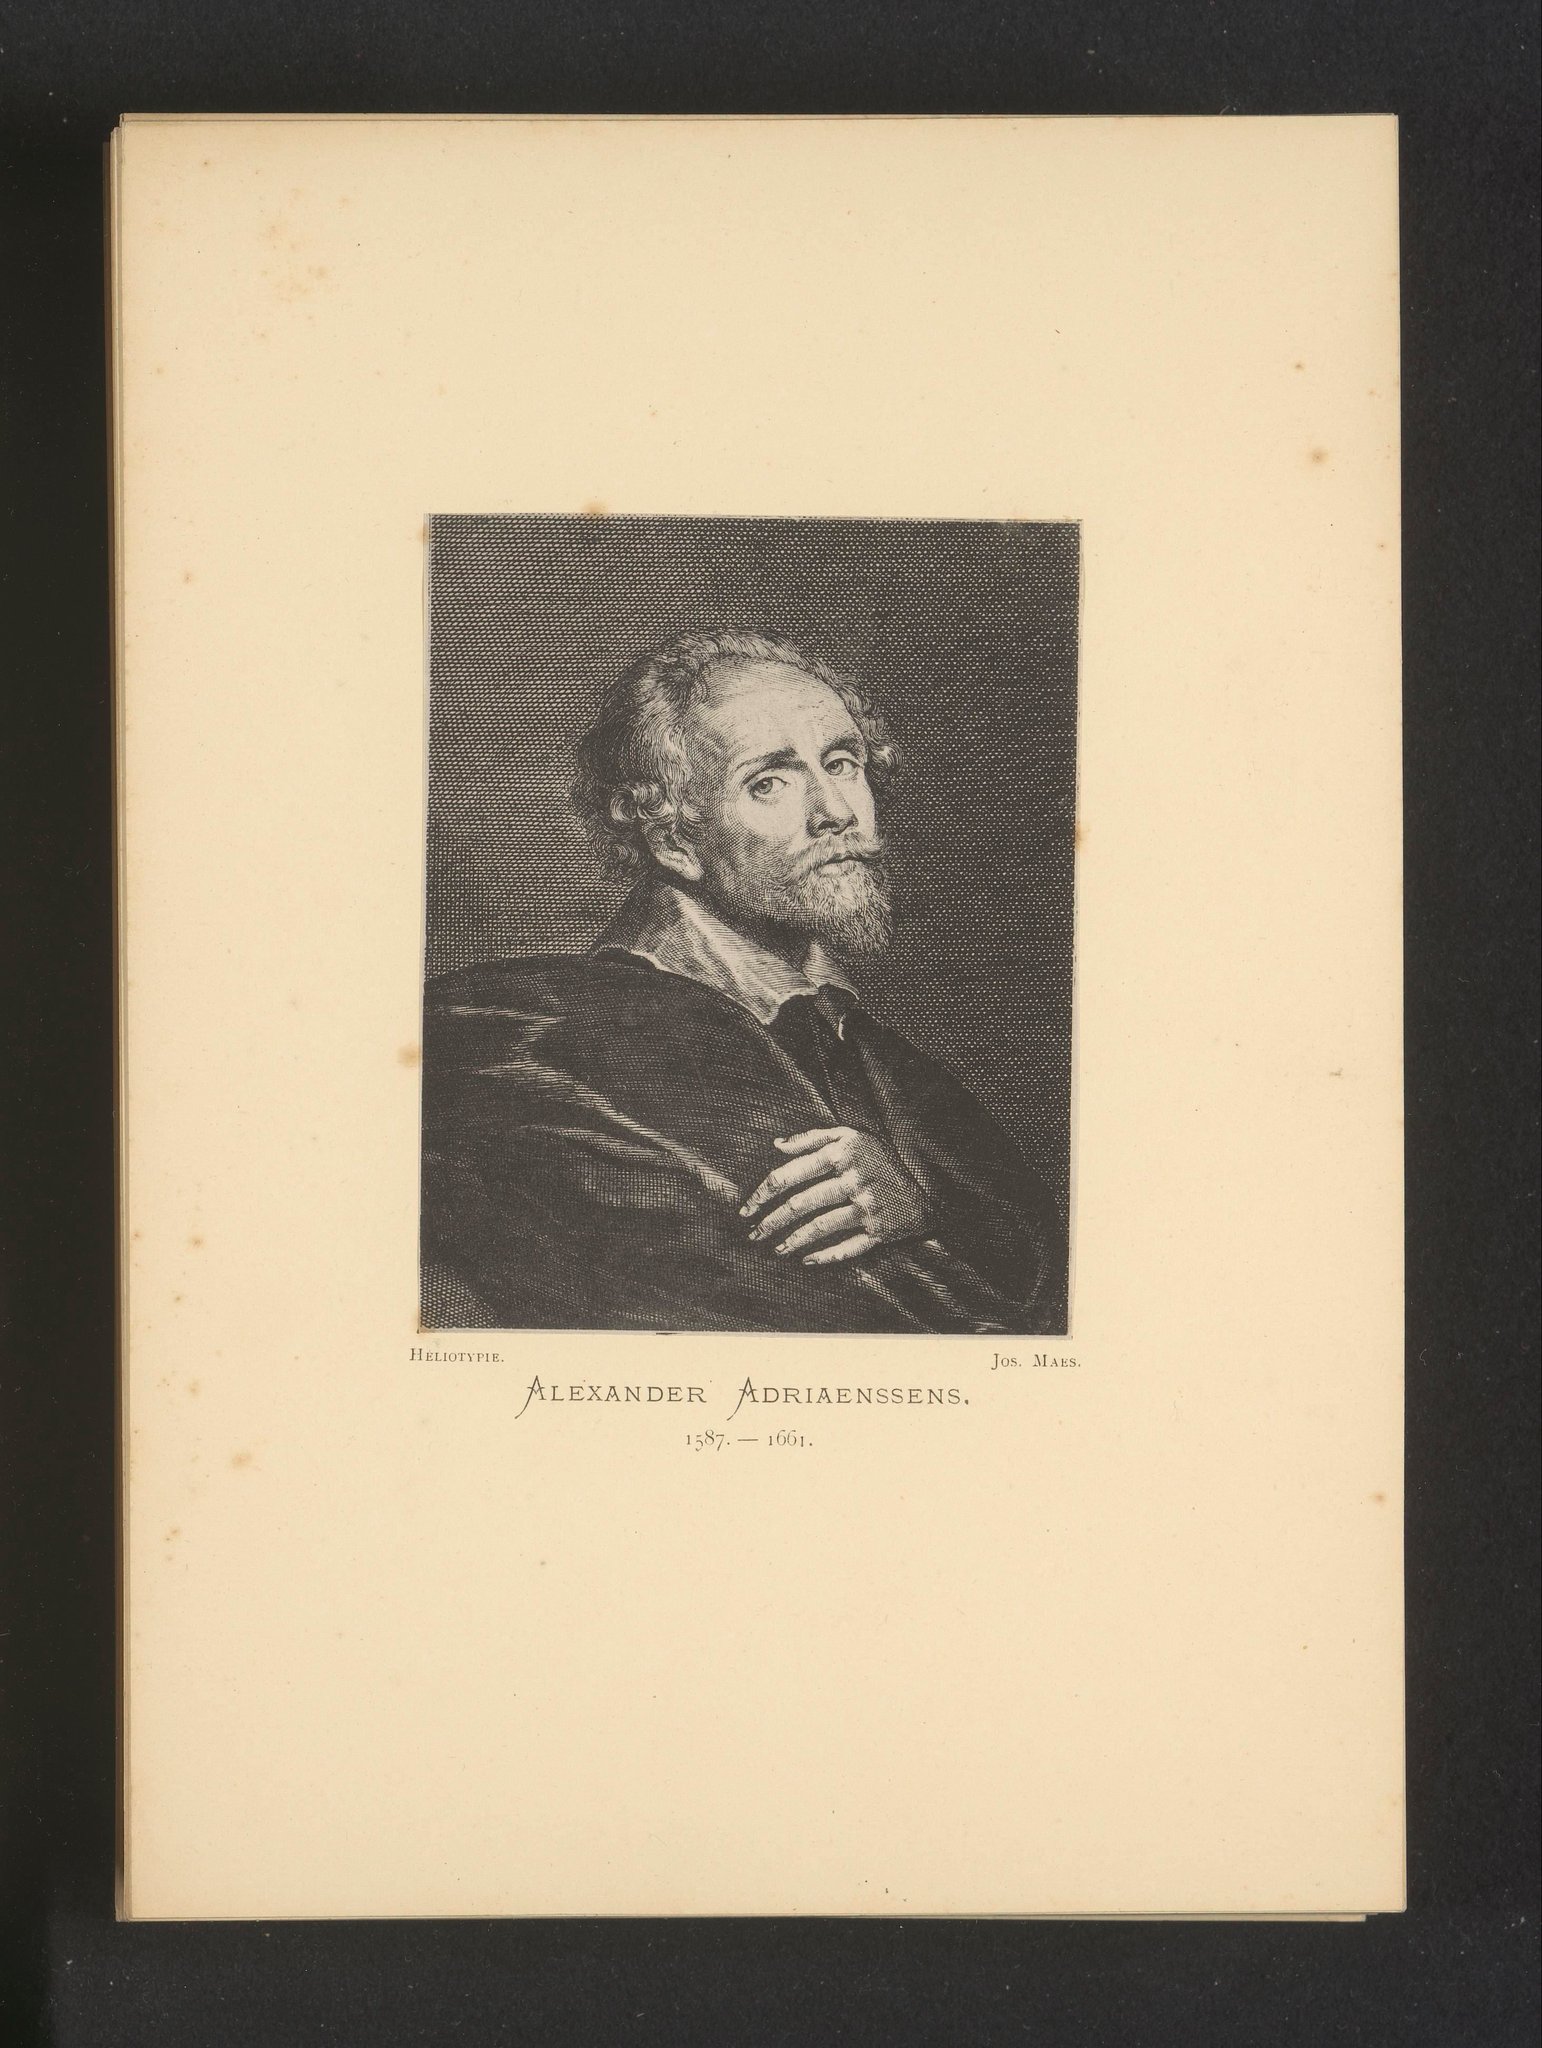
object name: reproduction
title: Alexander Adriaenssens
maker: joseph maes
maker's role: fotograaf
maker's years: 1838-1908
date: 1872-1877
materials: cardboard, paper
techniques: photograph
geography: antwerp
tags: antwerp, painter, alexander adriaenssen, historical persons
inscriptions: inscription: ‘1587. - 1661.’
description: Deze prent maakt deel uit van een omslag met 150 prenten en een katern met een lijst van afbeeldingen.